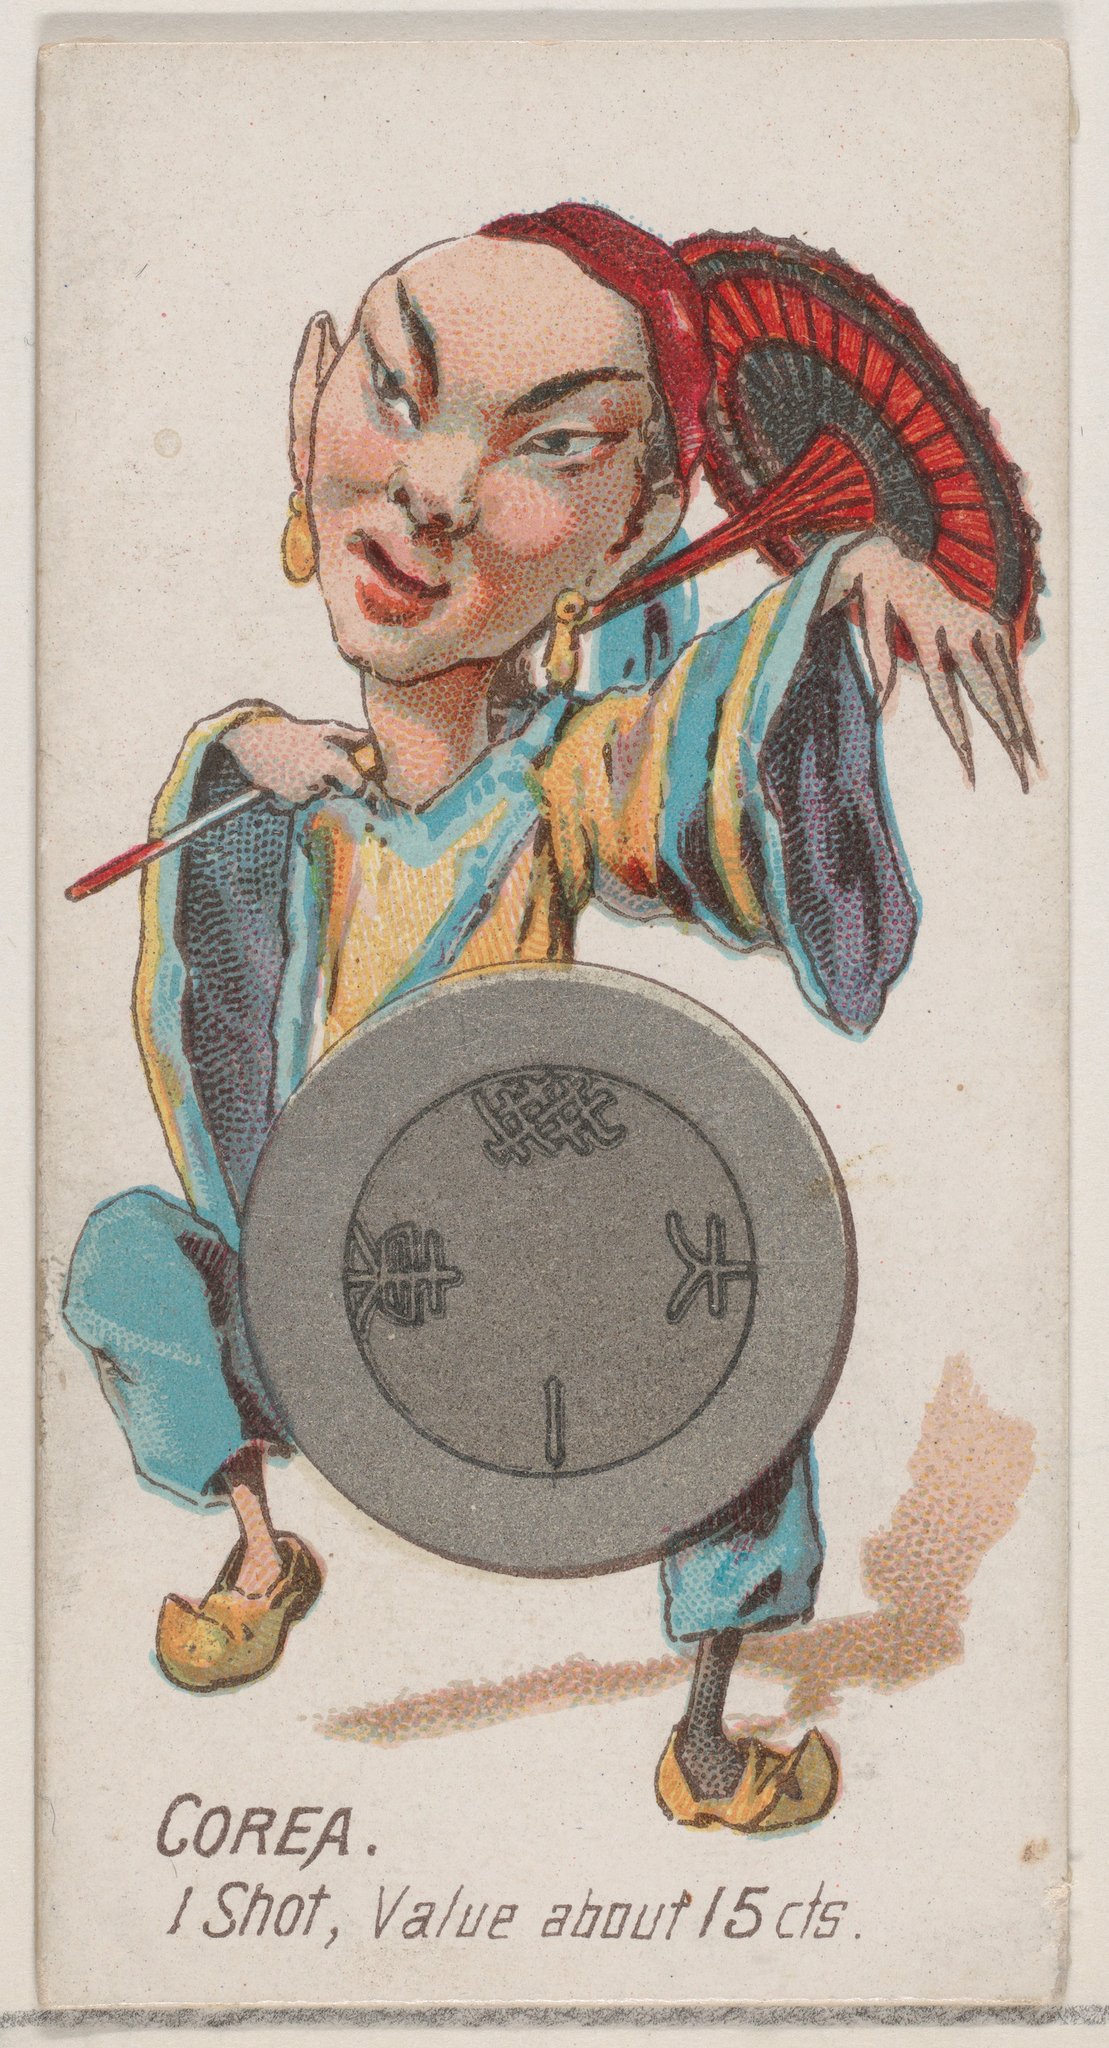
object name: print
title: Caricatured Korean, 1 Shot, from the series Coins of All Nations (N72, variation 2) for Duke brand cigarettes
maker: w. duke, sons & co.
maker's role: publisher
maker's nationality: american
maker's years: 1870-1920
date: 1889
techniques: color lithograph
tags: men,coins